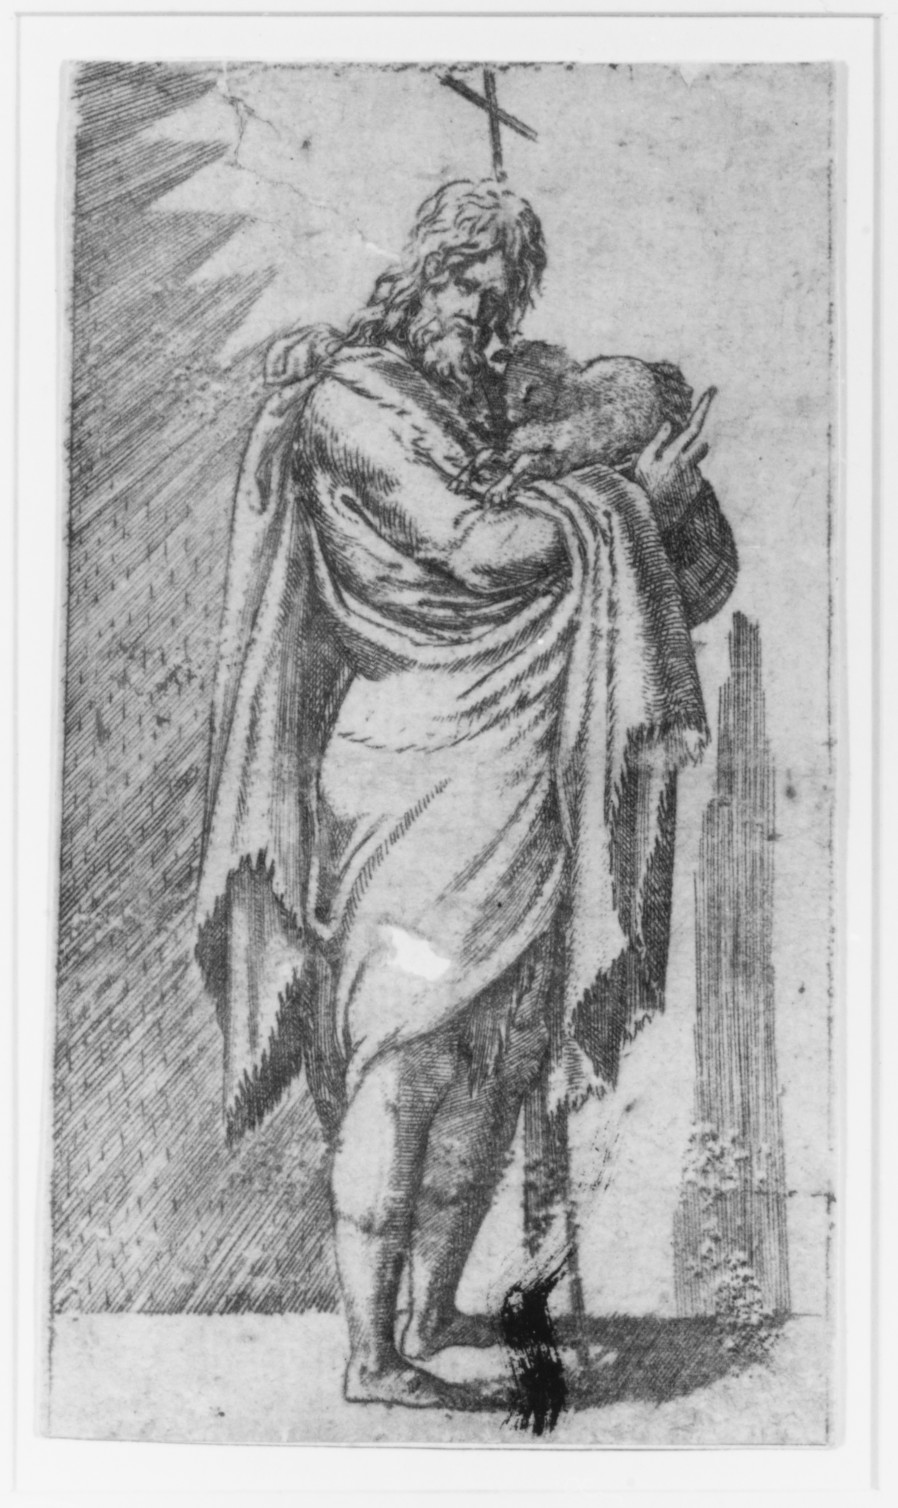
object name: print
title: St. John the Baptist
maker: battista angolo del moro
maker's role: artist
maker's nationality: italian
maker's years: 1515-1573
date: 1501-1600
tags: sheep,saint john the baptist,cross